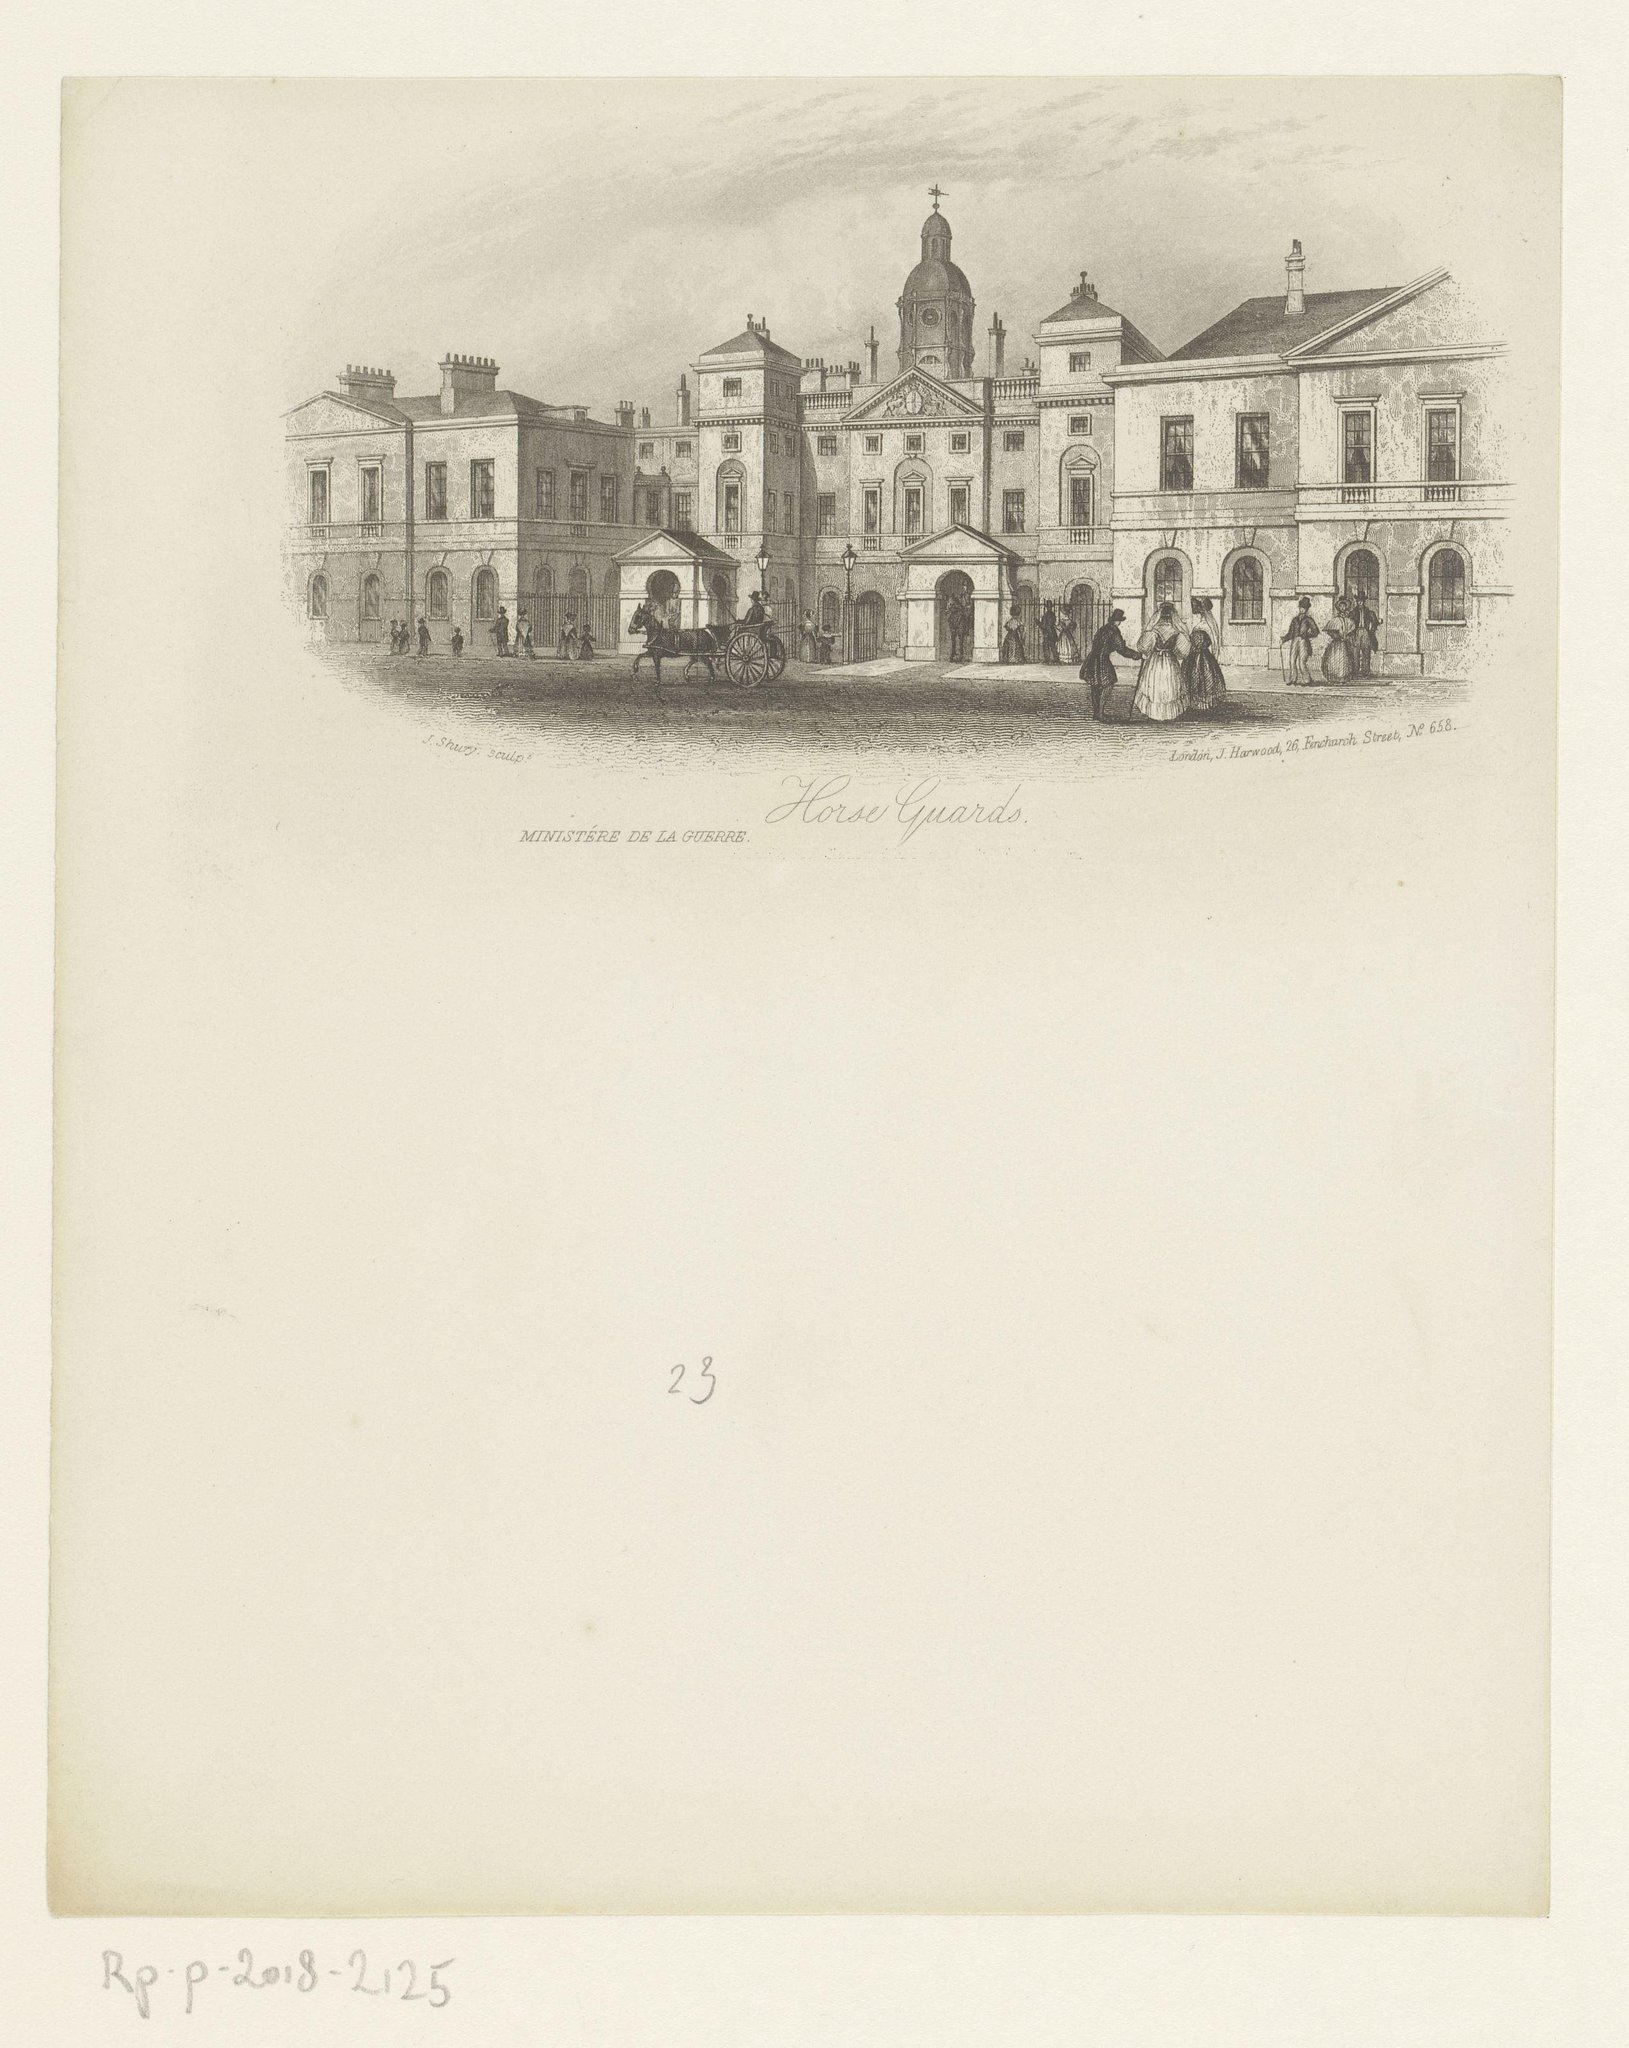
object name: print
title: Gezicht op de Horse Guards, te Londen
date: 1814-1844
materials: paper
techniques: engraving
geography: london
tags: ministerial council, edifice, e.g.: public building, department store, london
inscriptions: collector's mark: Lugt 2228